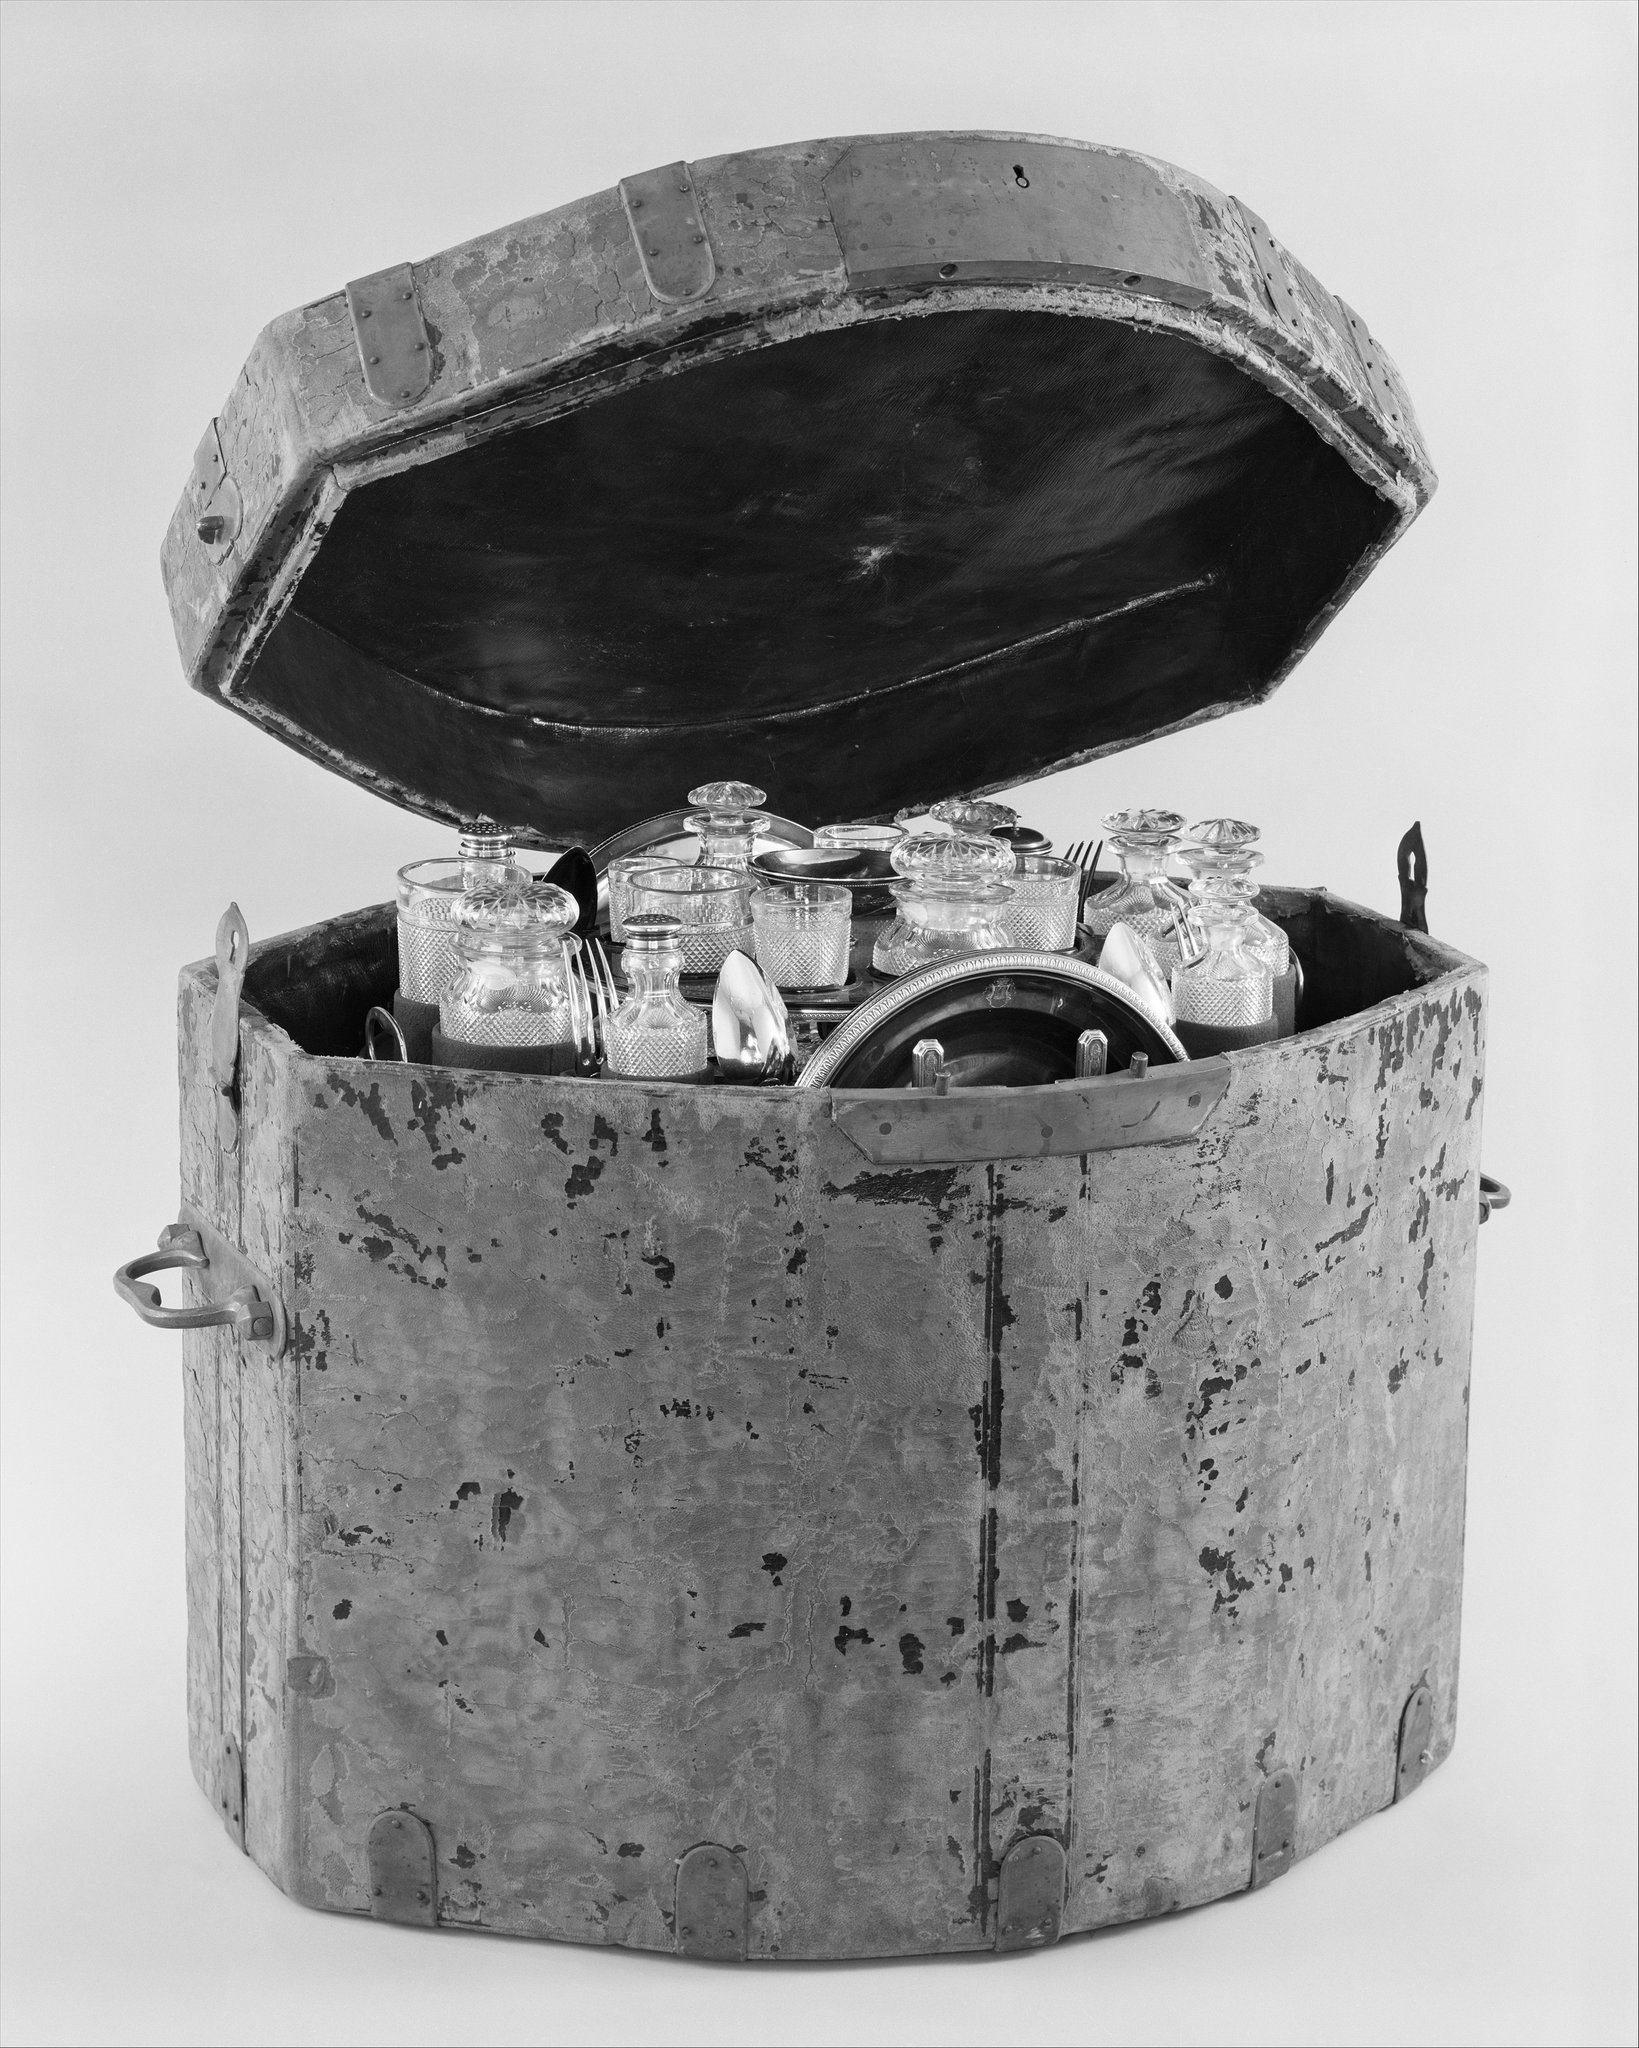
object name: stand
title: Stand (part of a dining service)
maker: martin-guillaume biennais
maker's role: silversmith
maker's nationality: french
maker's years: 1764-1843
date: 1805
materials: silver gilt, wood